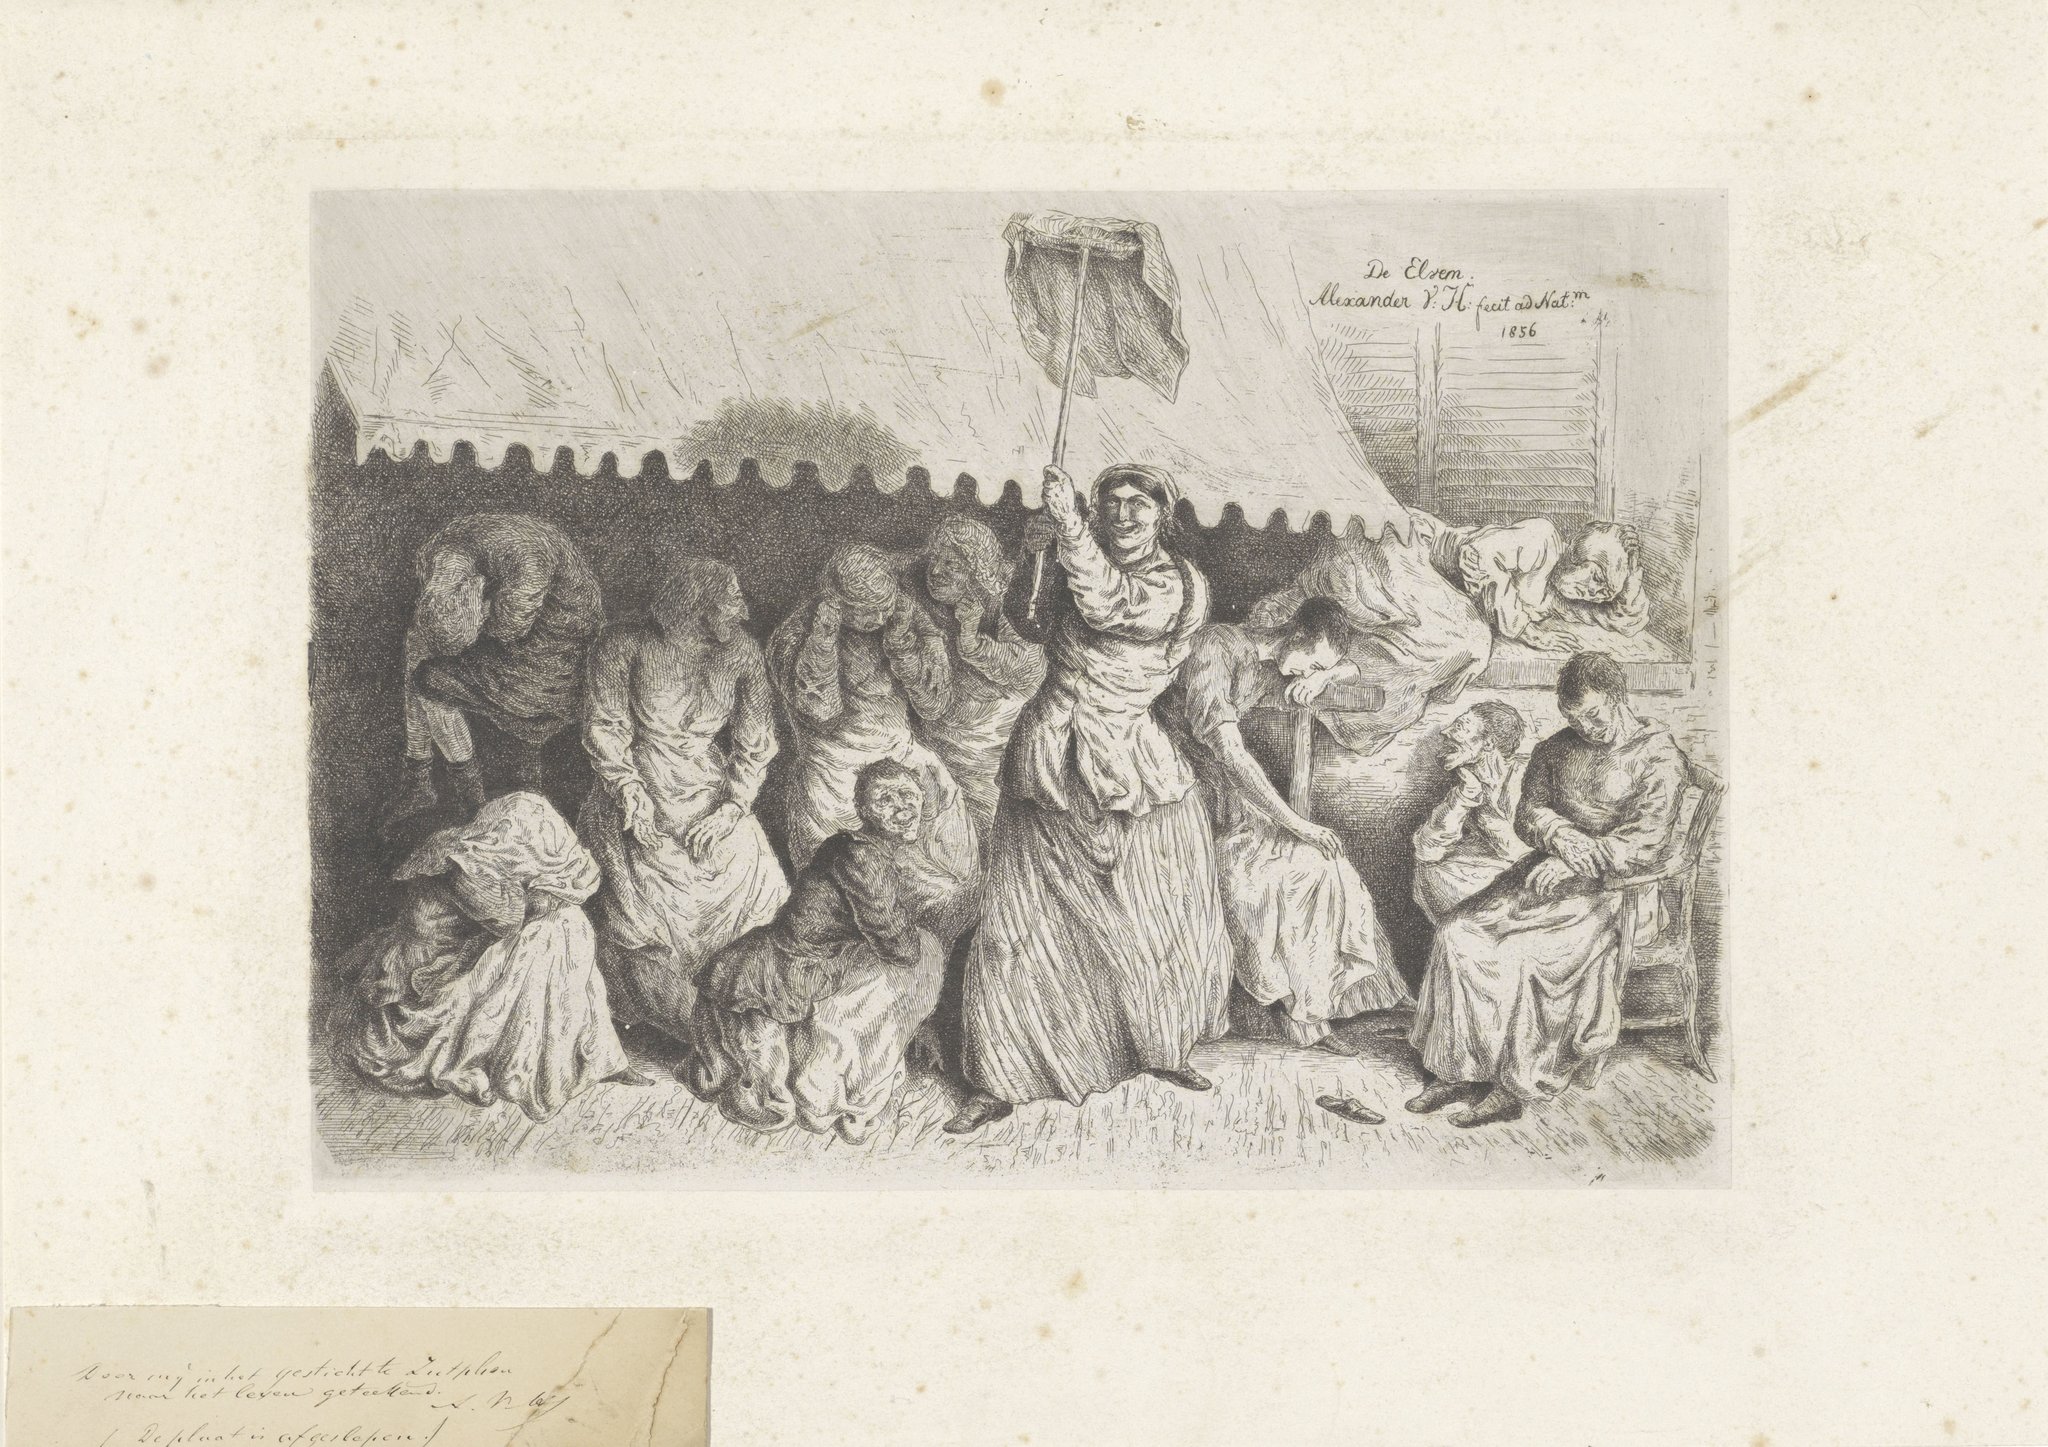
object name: print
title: De Elven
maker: alexander ver huell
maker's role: draughtsman, print maker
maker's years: 1822-1897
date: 1856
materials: paper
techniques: etching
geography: netherlands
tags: emotional illness, derangement, madness - aa - female human figure, lunatic asylum, mental home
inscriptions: collector's mark: Lugt 2760, collector's mark: Lugt 2228, inscription: ‘Door mij in het gesticht te Zutphen naar het leven geteekend.’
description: Vrouwelijke krankzinnigen in een interieur (van het gesticht te Zutphen). In het midden een vrouw die een doek met een bezem omhoog houdt.